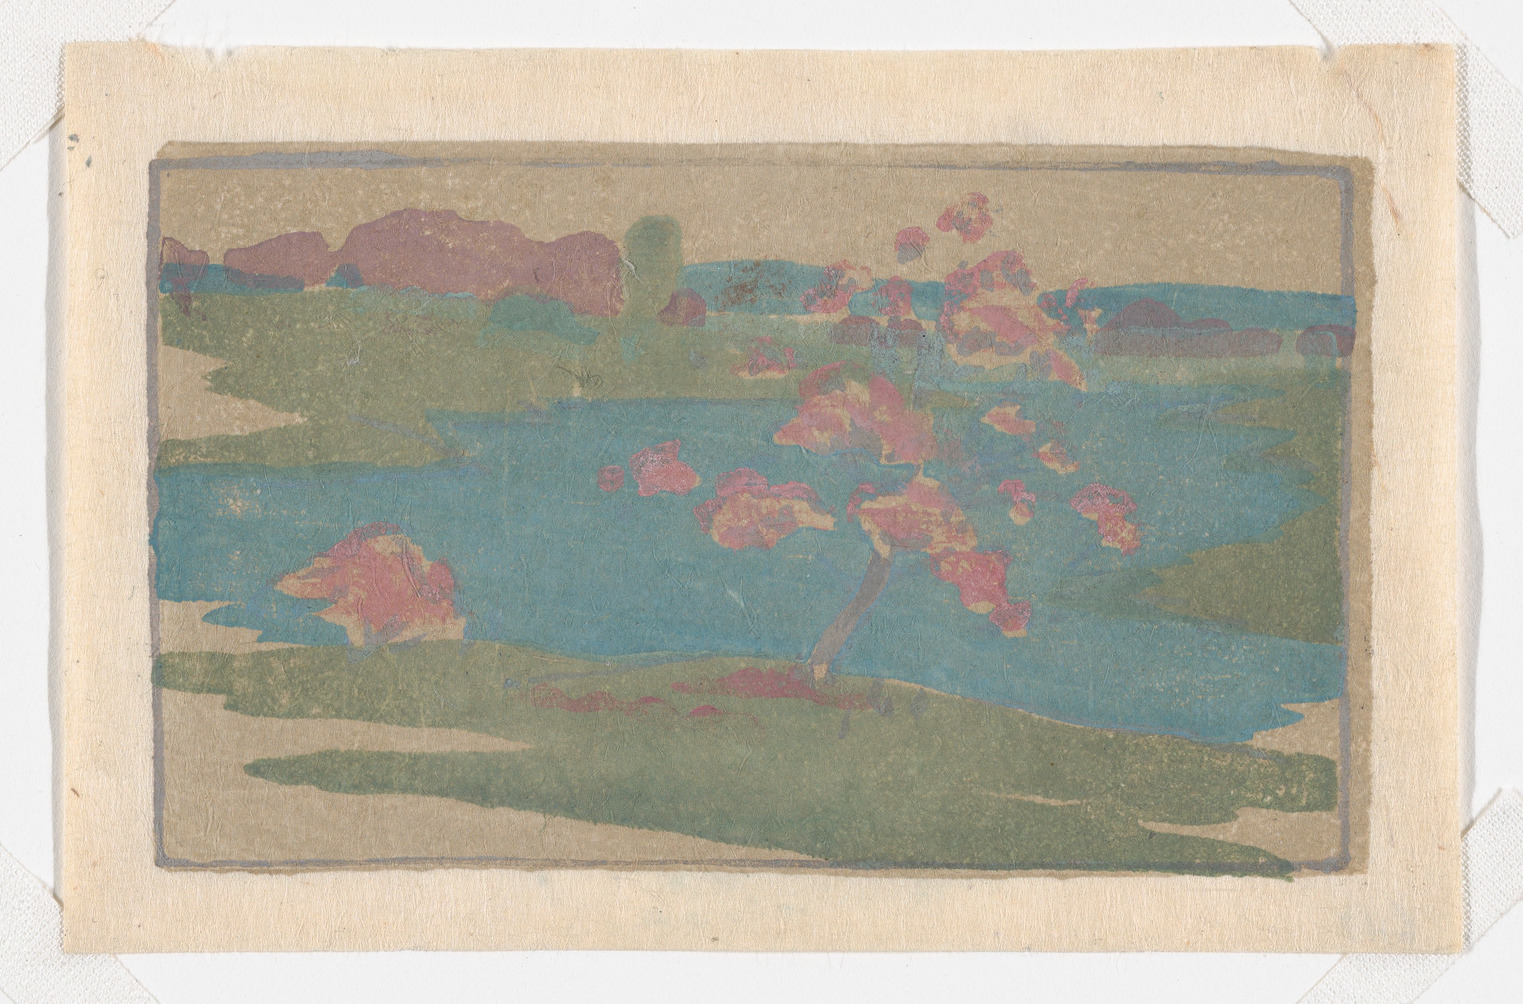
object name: woodcut, print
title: Nabby's Point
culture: american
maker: arthur wesley dow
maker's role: artist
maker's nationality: american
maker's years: 1857-1922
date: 1913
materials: paper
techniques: woodcut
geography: united states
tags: lakes,hills,trees